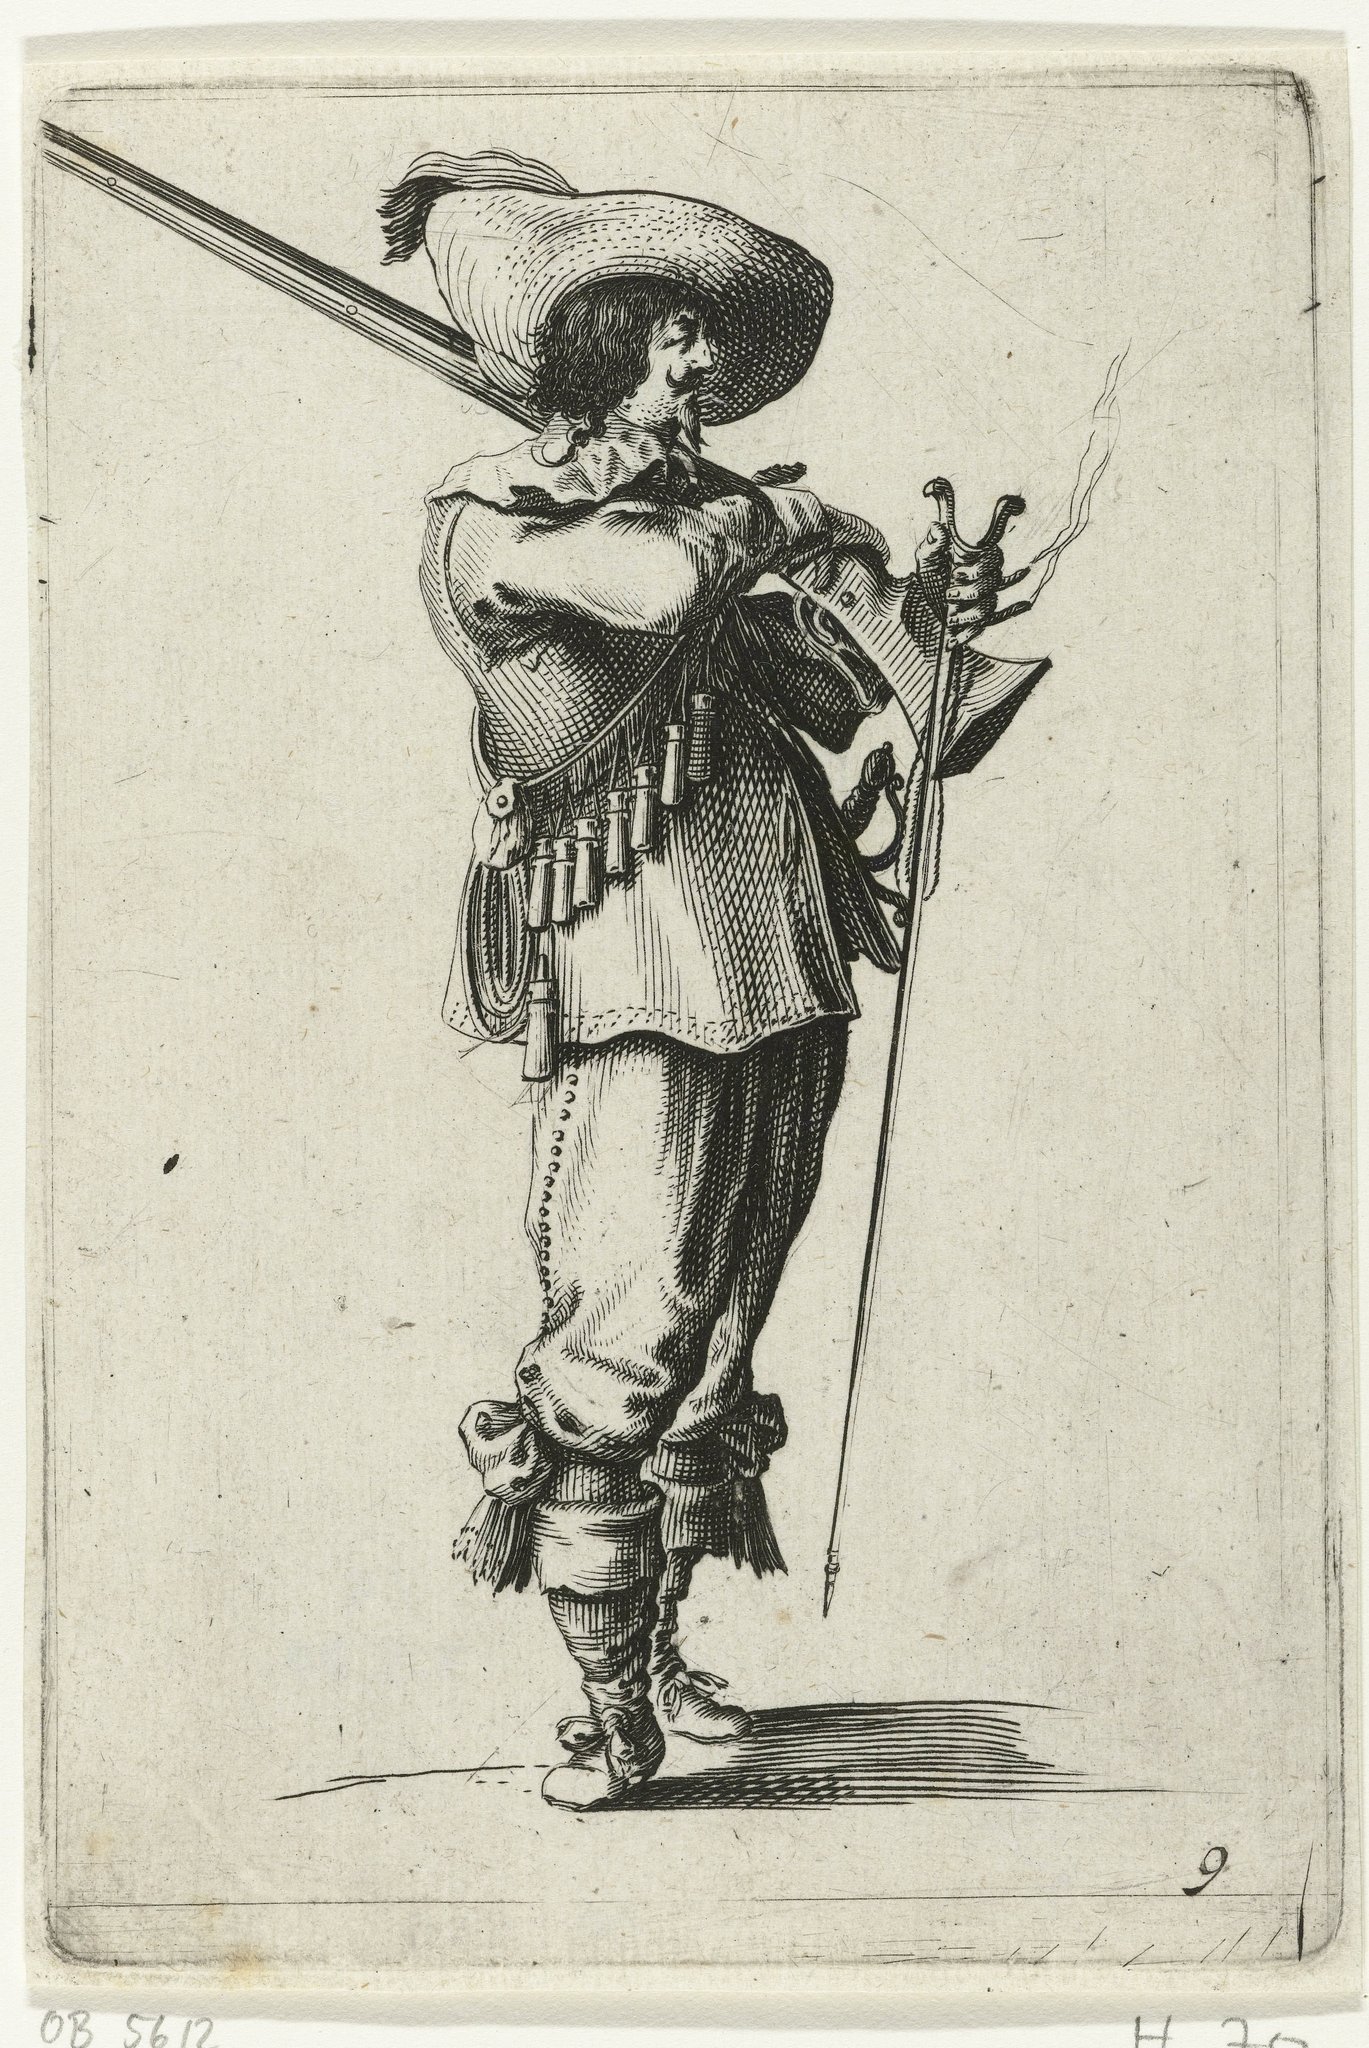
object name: costume print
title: Staande soldaat met musket over de schouder en geweerhouder in de linkerhand.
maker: salomon savery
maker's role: print maker, publisher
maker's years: 1594-1683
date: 1630-1665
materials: paper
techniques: engraving, etching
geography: amsterdam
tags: head-gear: hat (+ men's clothes), weapons, clothes, costume (+ men's clothes), the soldier; the soldier's life, trousers, breeches, etc. (breeches) (+ men's clothes), clothing for the upper part of the body (doublet) (+ men's clothes), boots (+ men's clothes)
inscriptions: collector's mark: Lugt 240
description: De prent maakt deel uit van een tiendelige serie met voorstellingen van gewapende officieren en soldaten, gekleed volgens de Nederlandse mode ca. 1625-1635.